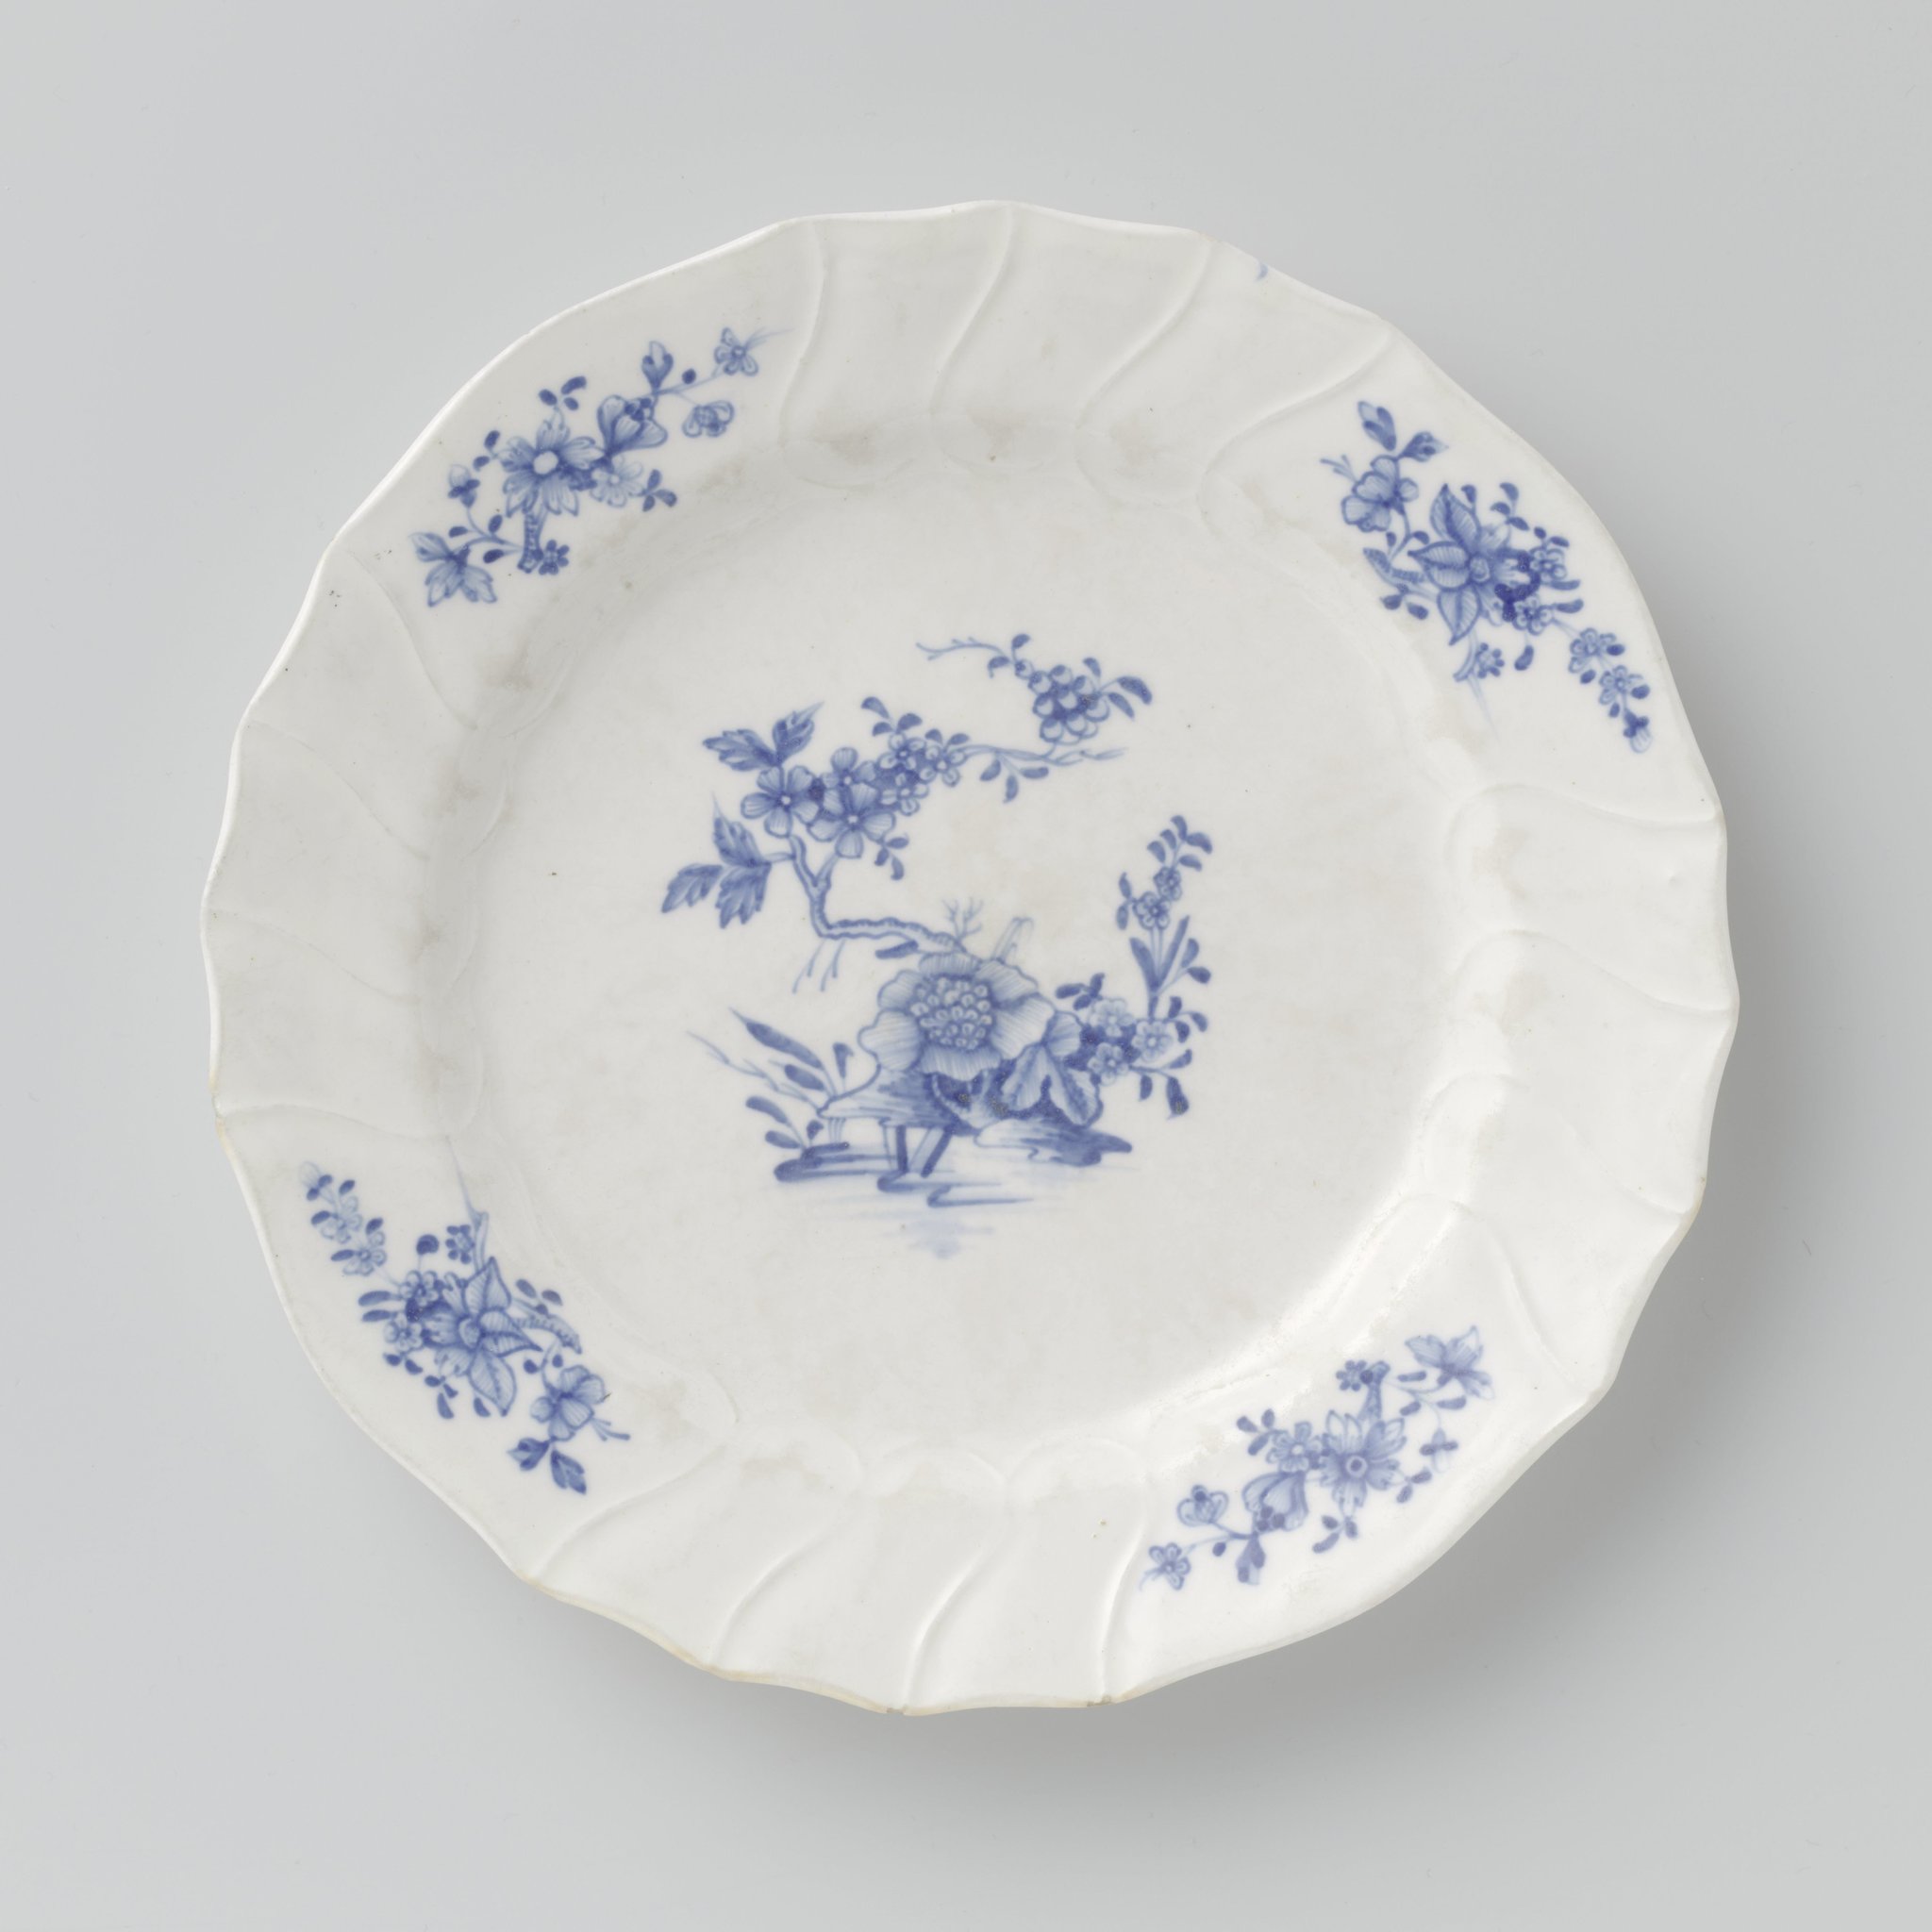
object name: plate dish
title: Plate with flowering plants and flower sprays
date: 1890-1900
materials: cobalt, glaze, paint, porcelain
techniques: firing, turning, vitrification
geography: doornik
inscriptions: mark: ‘gekruiste zwaarden met vier kruizen/ A’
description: Bord van soft-paste porselein (pâte tendre) met een geschulpte rand, beschilderd in onderglazuur blauw. Op het plat een bloeiende plant. De rand, doorlopend op de wand, is licht gemodelleerd in telkens drie smalle en één breed getordeerd vak. In de vier brede vakken een bloemtak. Gemerkt op de onderzijde met de gekruiste zwaarden met vier kruizen en een A.